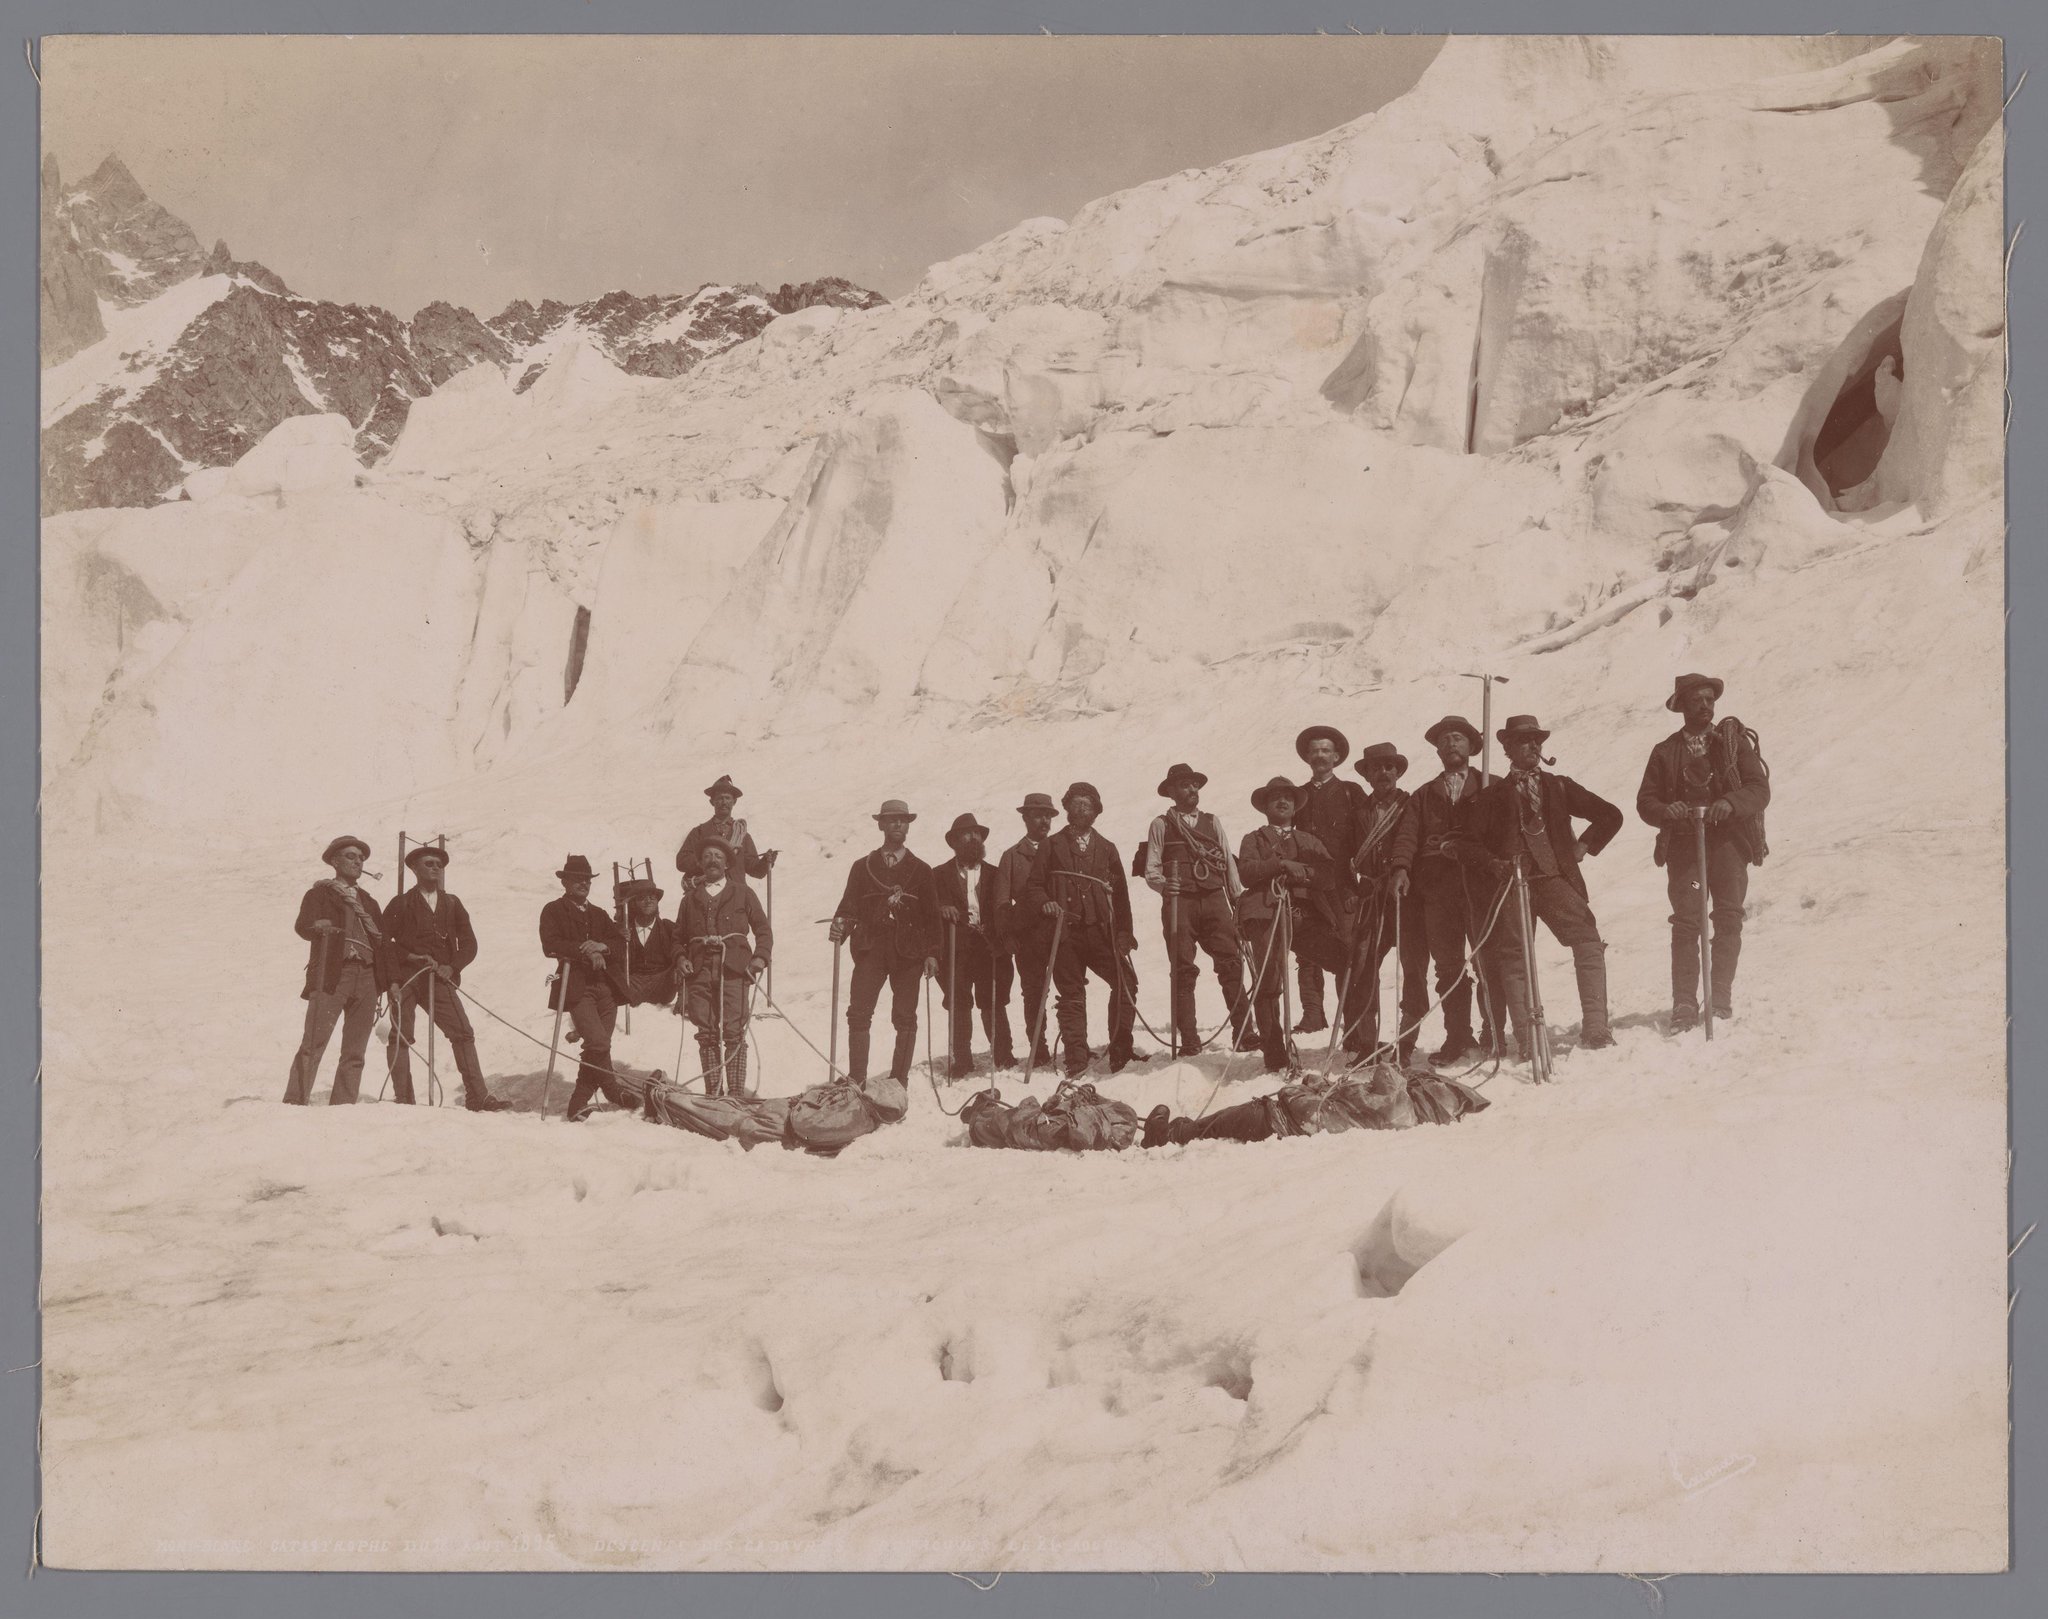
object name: photograph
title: Groepsportret van onbekende bergers acht dagen na een ramp in het Mont Blanc Massief op 18 augustus 1895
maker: Anonymous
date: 1895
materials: paper, textile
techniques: collodion silver print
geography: chamonix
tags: finding a dead person, mountains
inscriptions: inscription: ‘zamenauf [?] 3 corps de touristes’, inscription: ‘ENTOILAGE/ DOBLER, PARIS/ LINOTYPE’